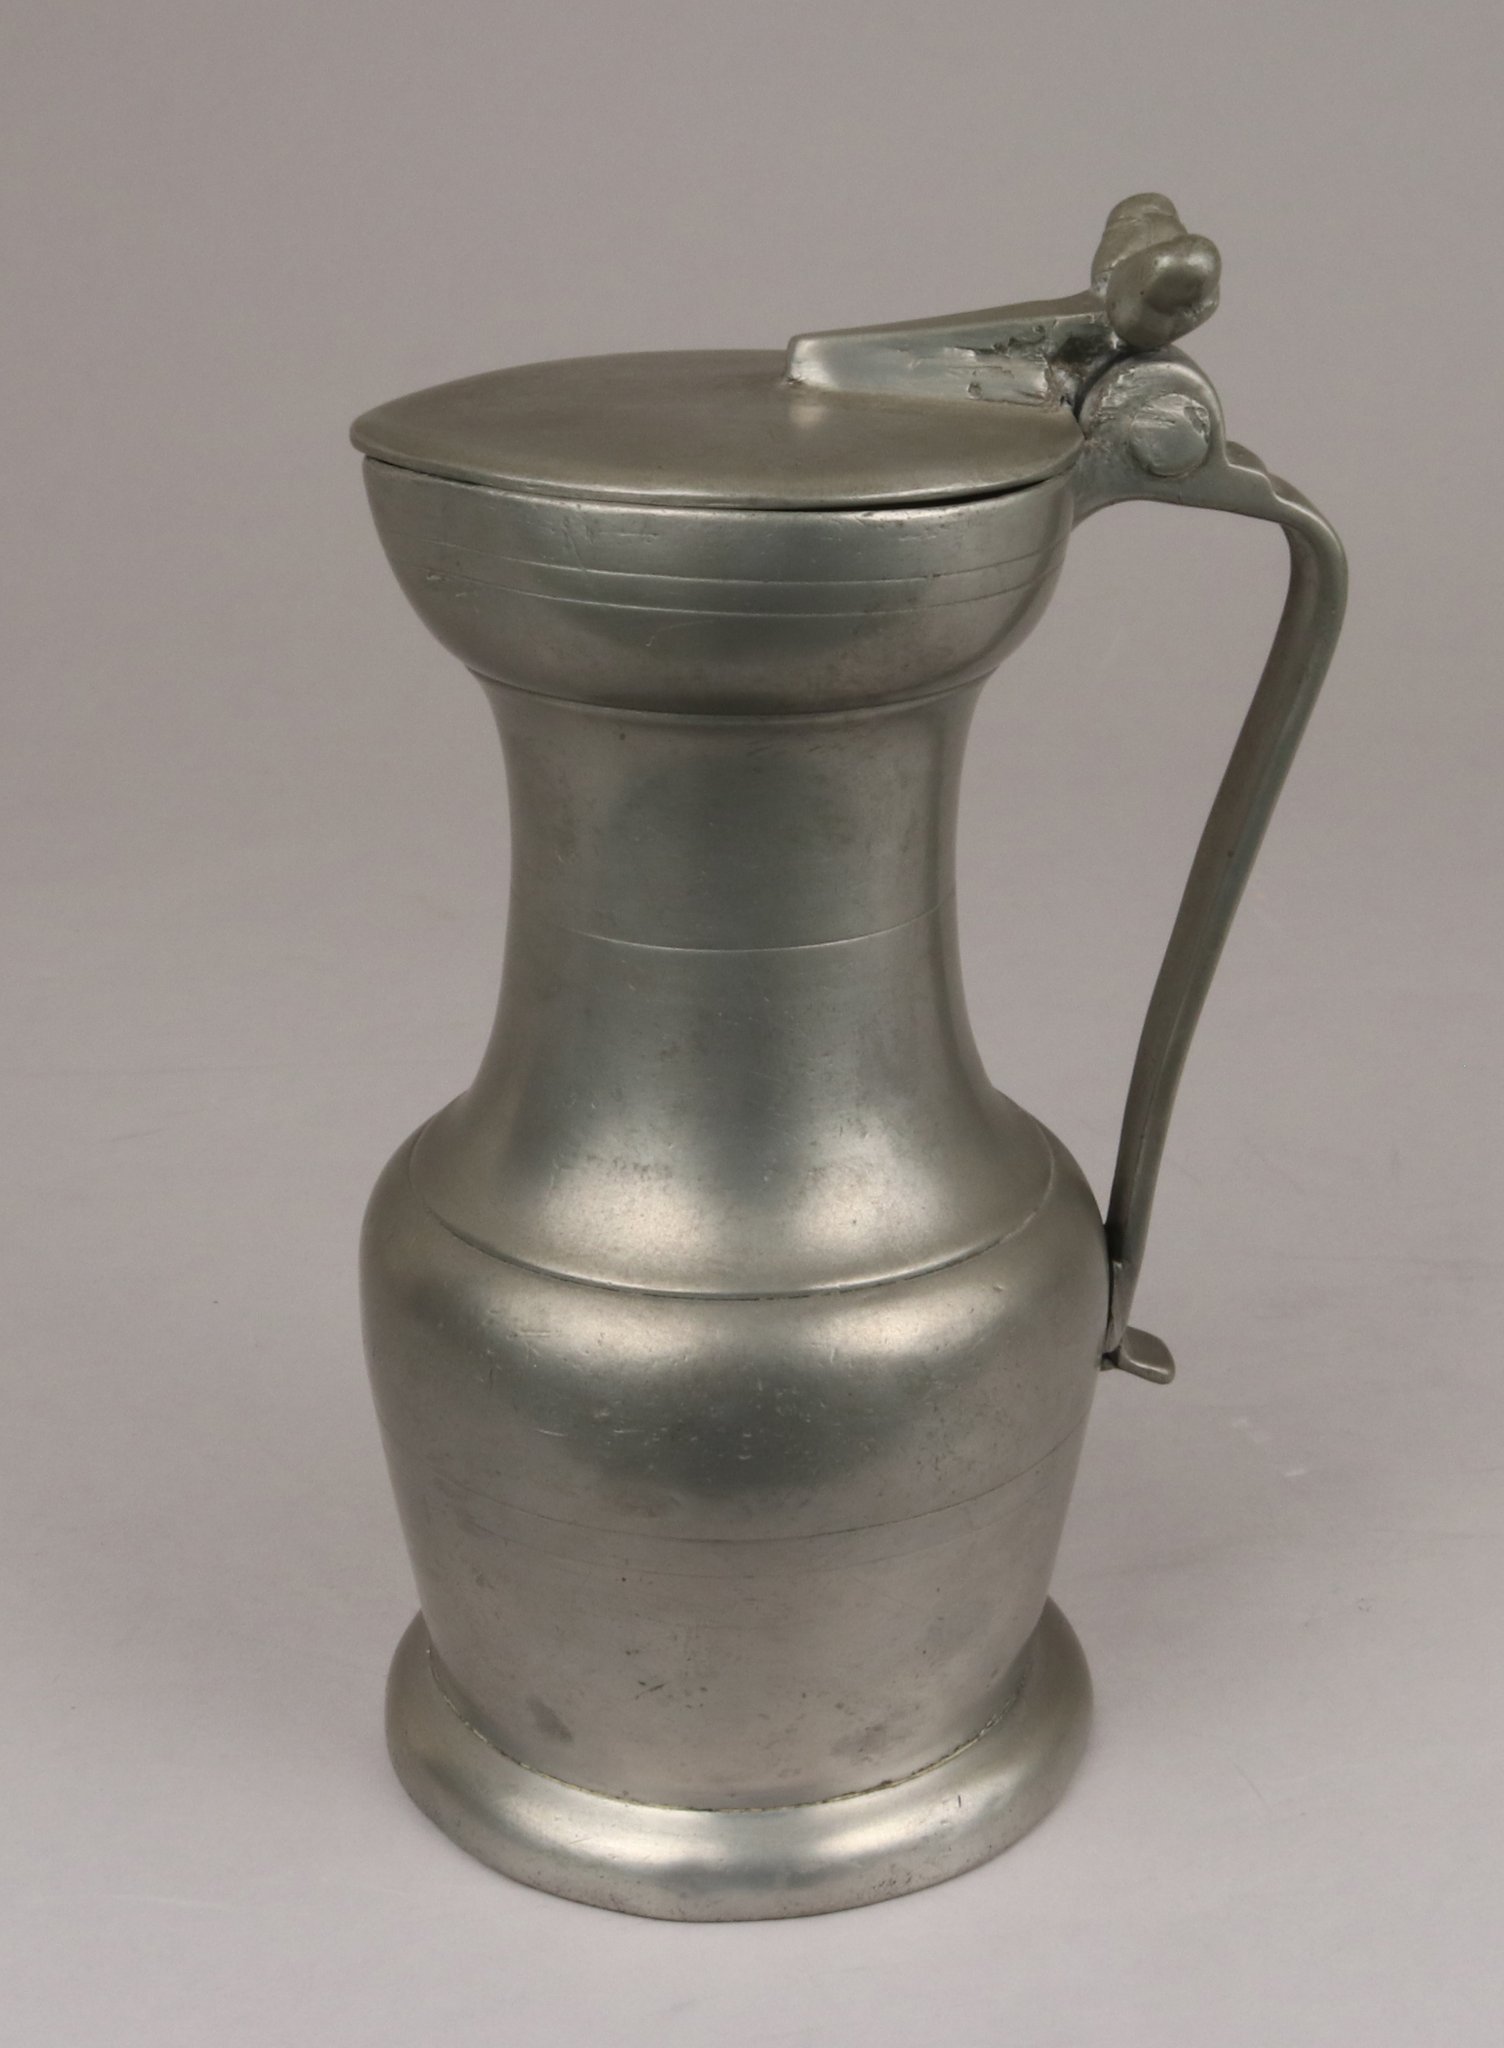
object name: measure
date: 1701-1800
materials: pewter